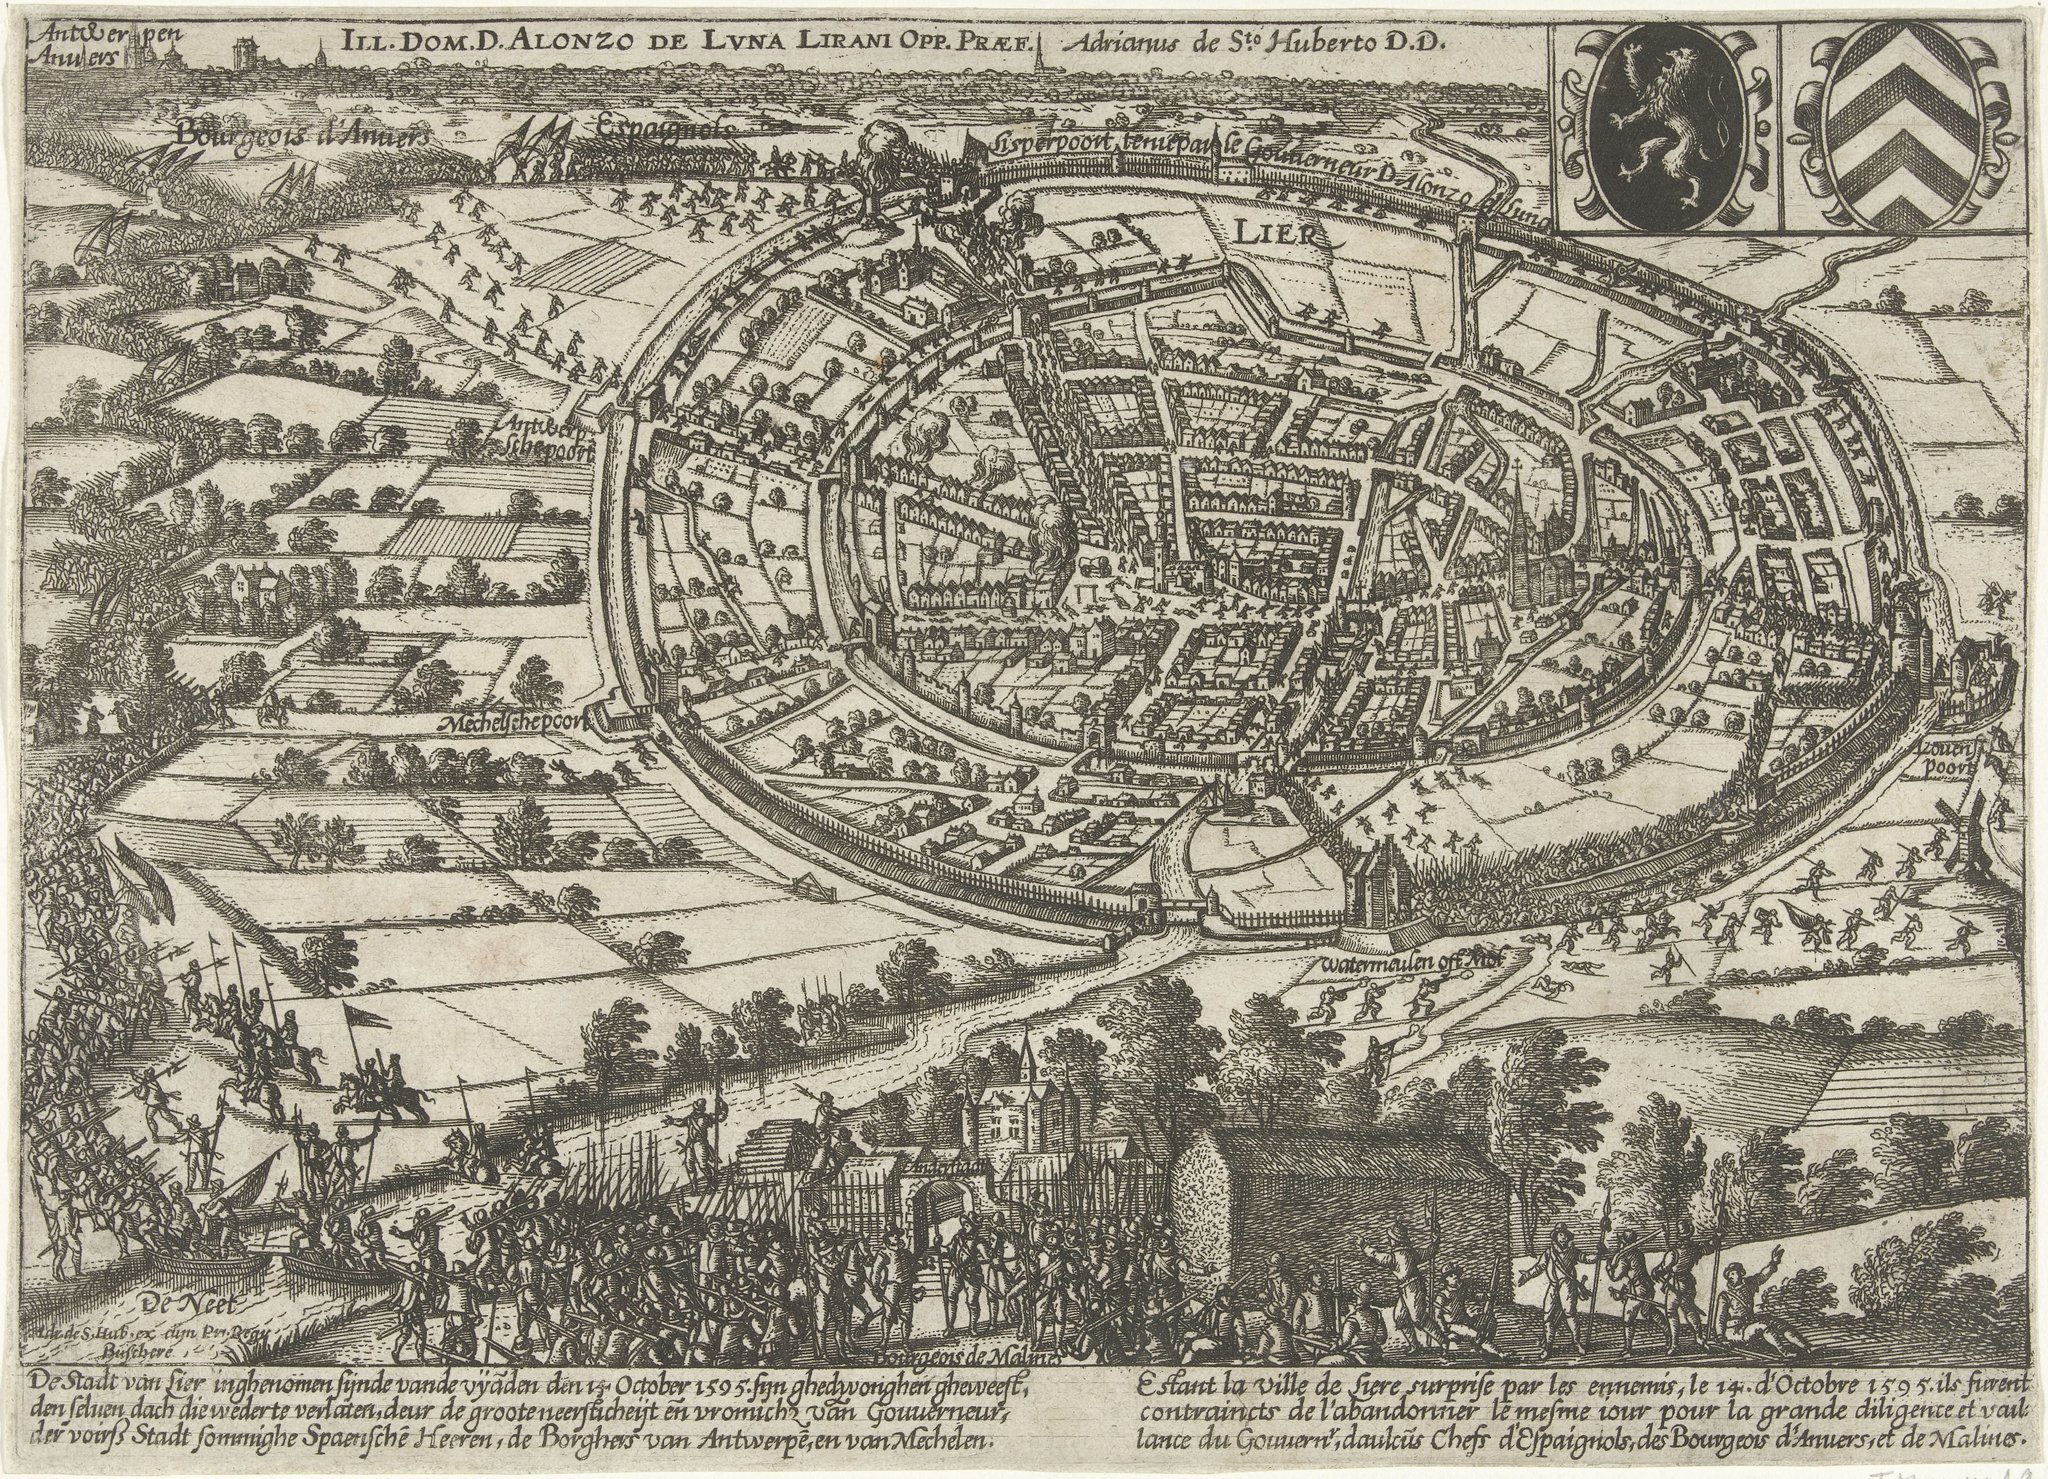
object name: print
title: Lier ingenomen en verlaten door het Staatse leger, 1595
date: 1595-1597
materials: paper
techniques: etching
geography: southern netherlands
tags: alonzo de luna, capture of city (after the siege), lierre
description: De stad Lier ingenomen en op dezelfde dag verlaten door het Staatse leger, 14 oktober 1595. Gewapende burgers trekken vanuit Antwerpen op naar de stad, op de voorgrond de burgers van Mechelen. Met onderschrift van 3 regels in het Nederlands en 3 regels in het Frans. Rechtsboven de wapens van stad en provincie.